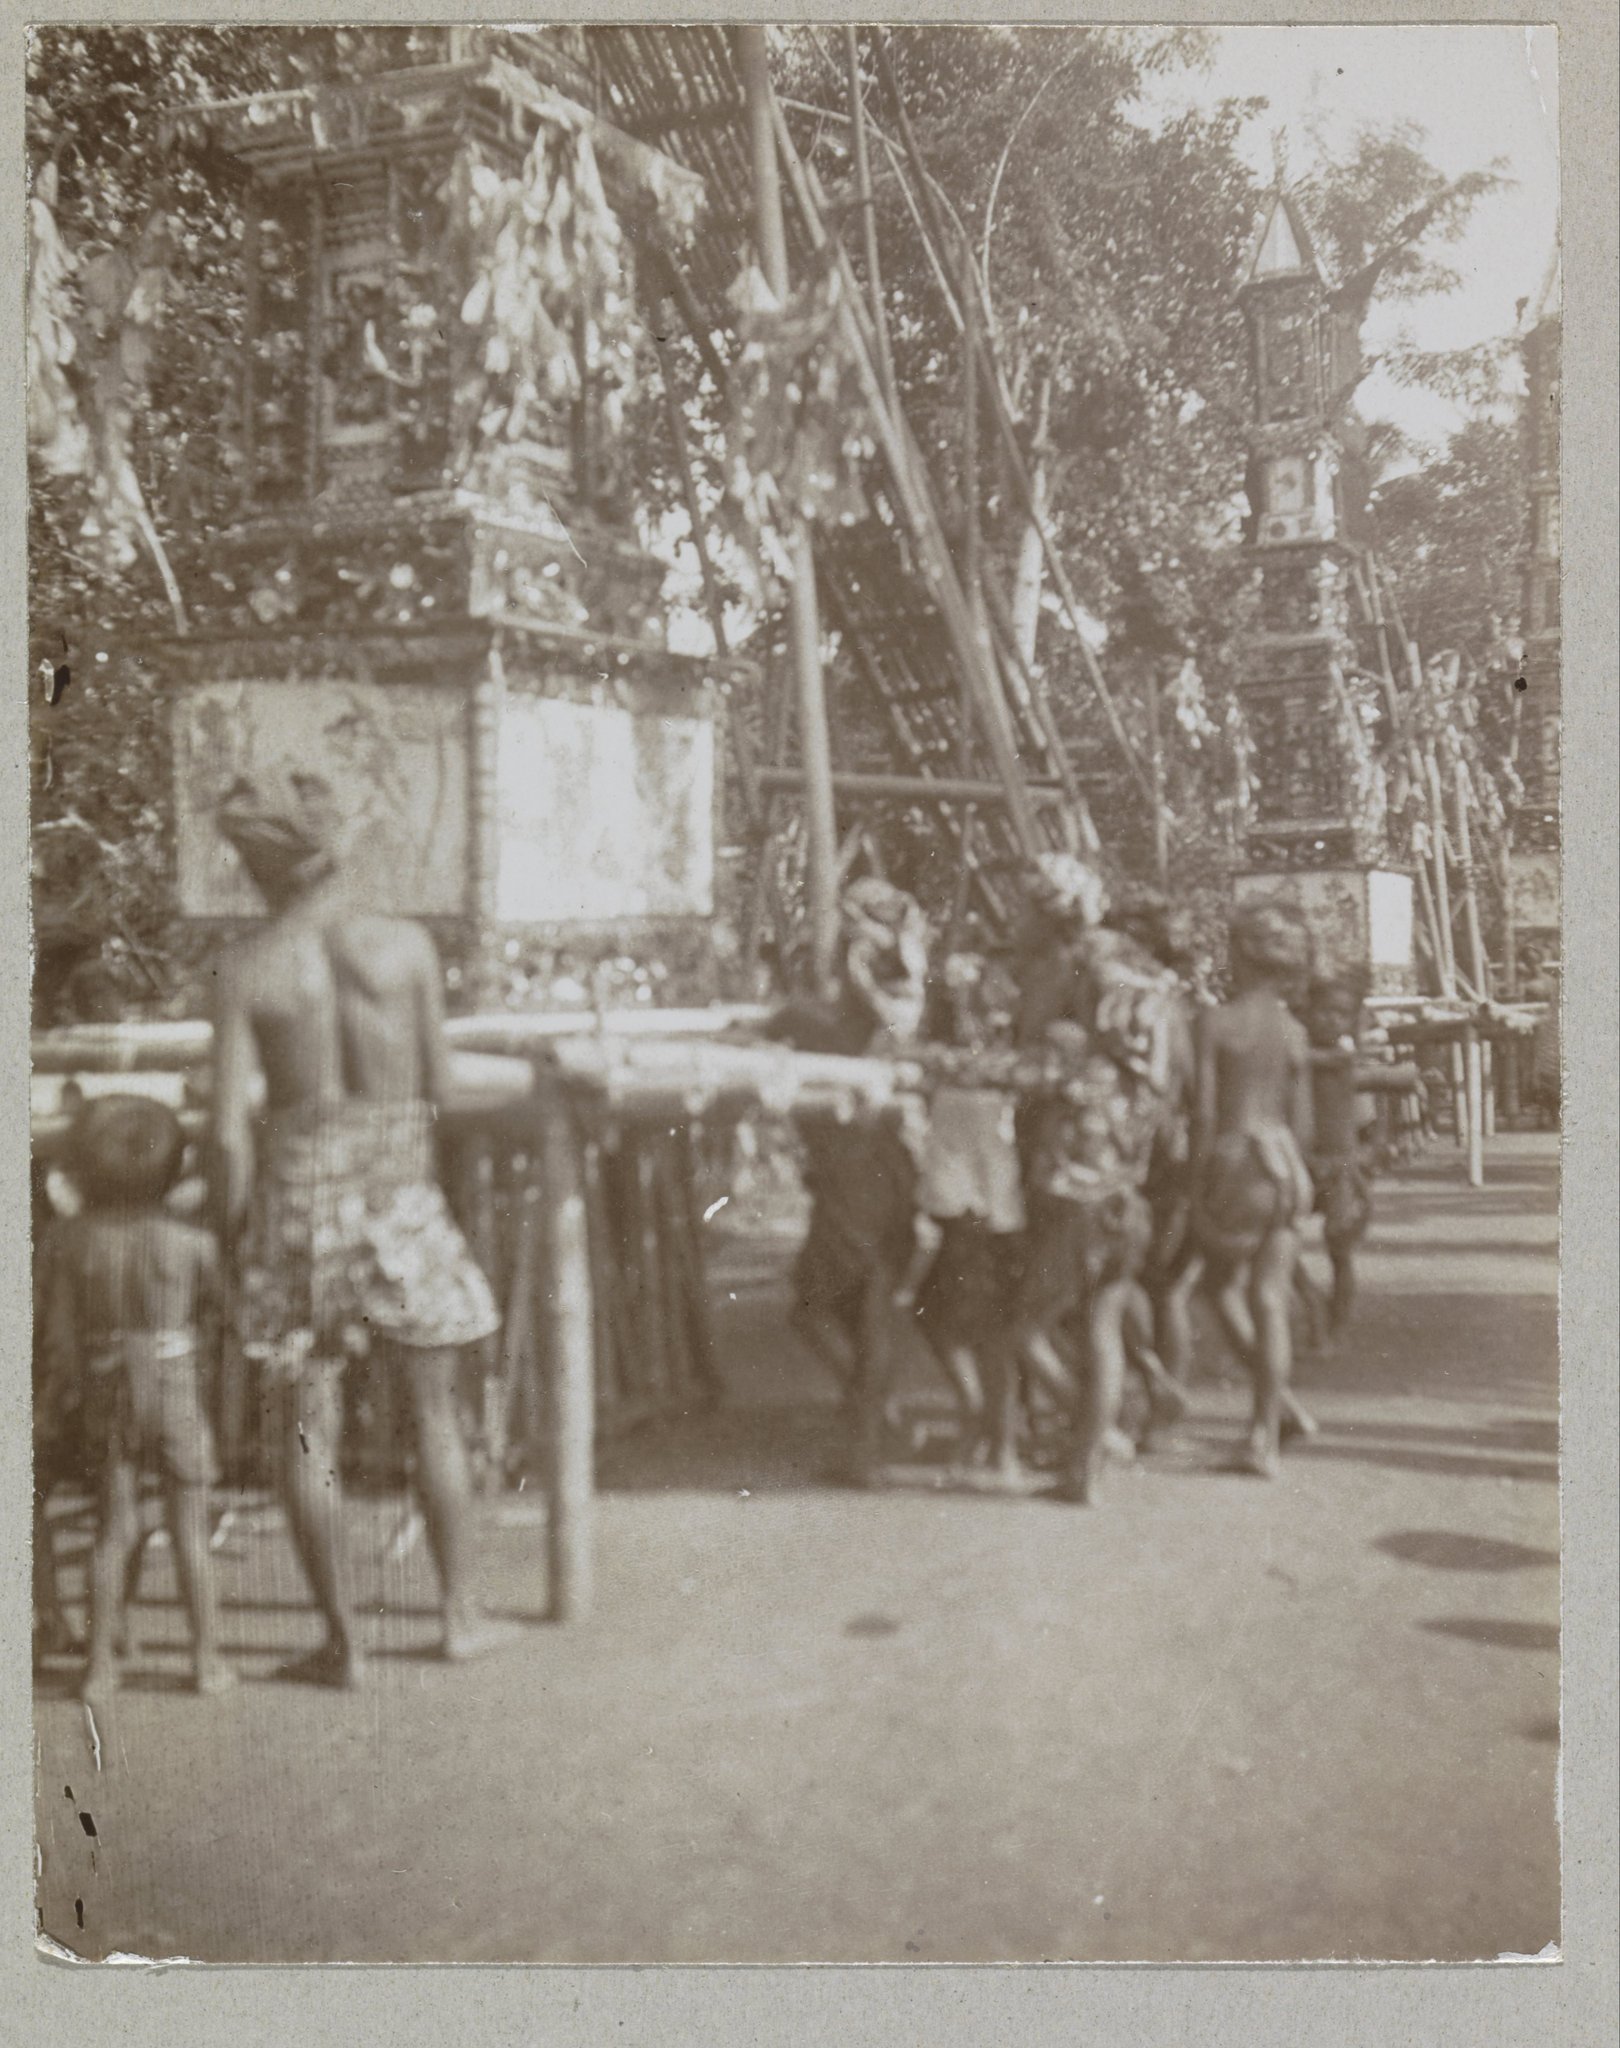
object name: photograph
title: Lijkbaren, Bali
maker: Anonymous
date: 1910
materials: cardboard, paper, photographic support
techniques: collodion silver print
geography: bali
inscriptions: annotation: ‘2_3_4) lijkverbrandingsfeesten te Bali 1910.’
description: Foto genomen tijdens lijkverbrandingsfeesten op Bali in 1910.